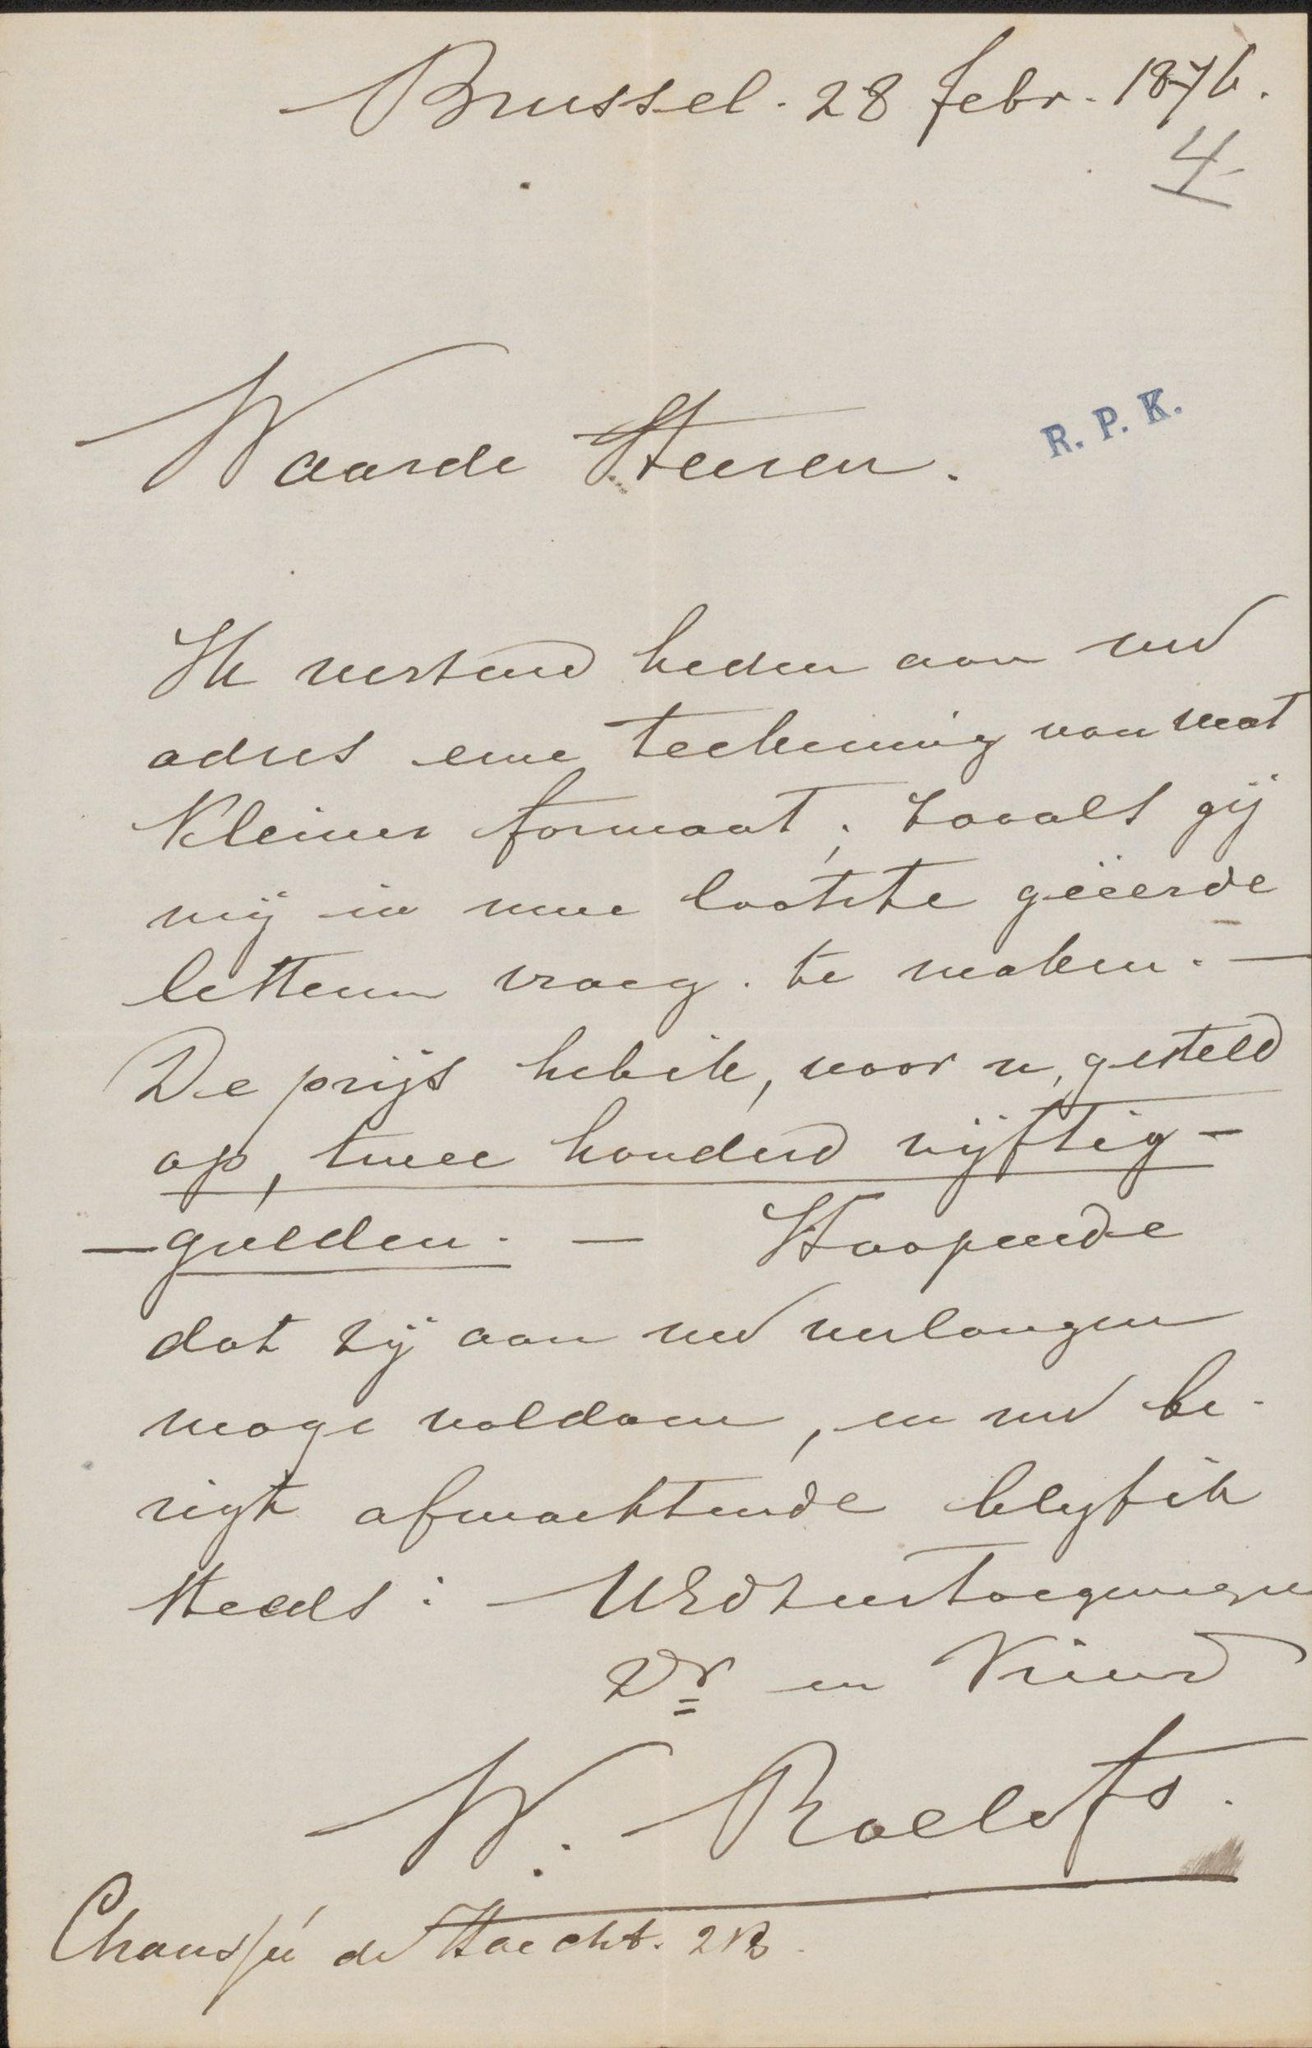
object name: letter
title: Brief aan Frans Buffa en Zonen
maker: willem roelofs (i)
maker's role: draughtsman, painter, print maker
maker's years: 1822-1897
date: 1876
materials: ink, paper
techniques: pen, writing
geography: brussels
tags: publisher, art trade, art shop, drawing, money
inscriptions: collector's mark: Lugt 2233